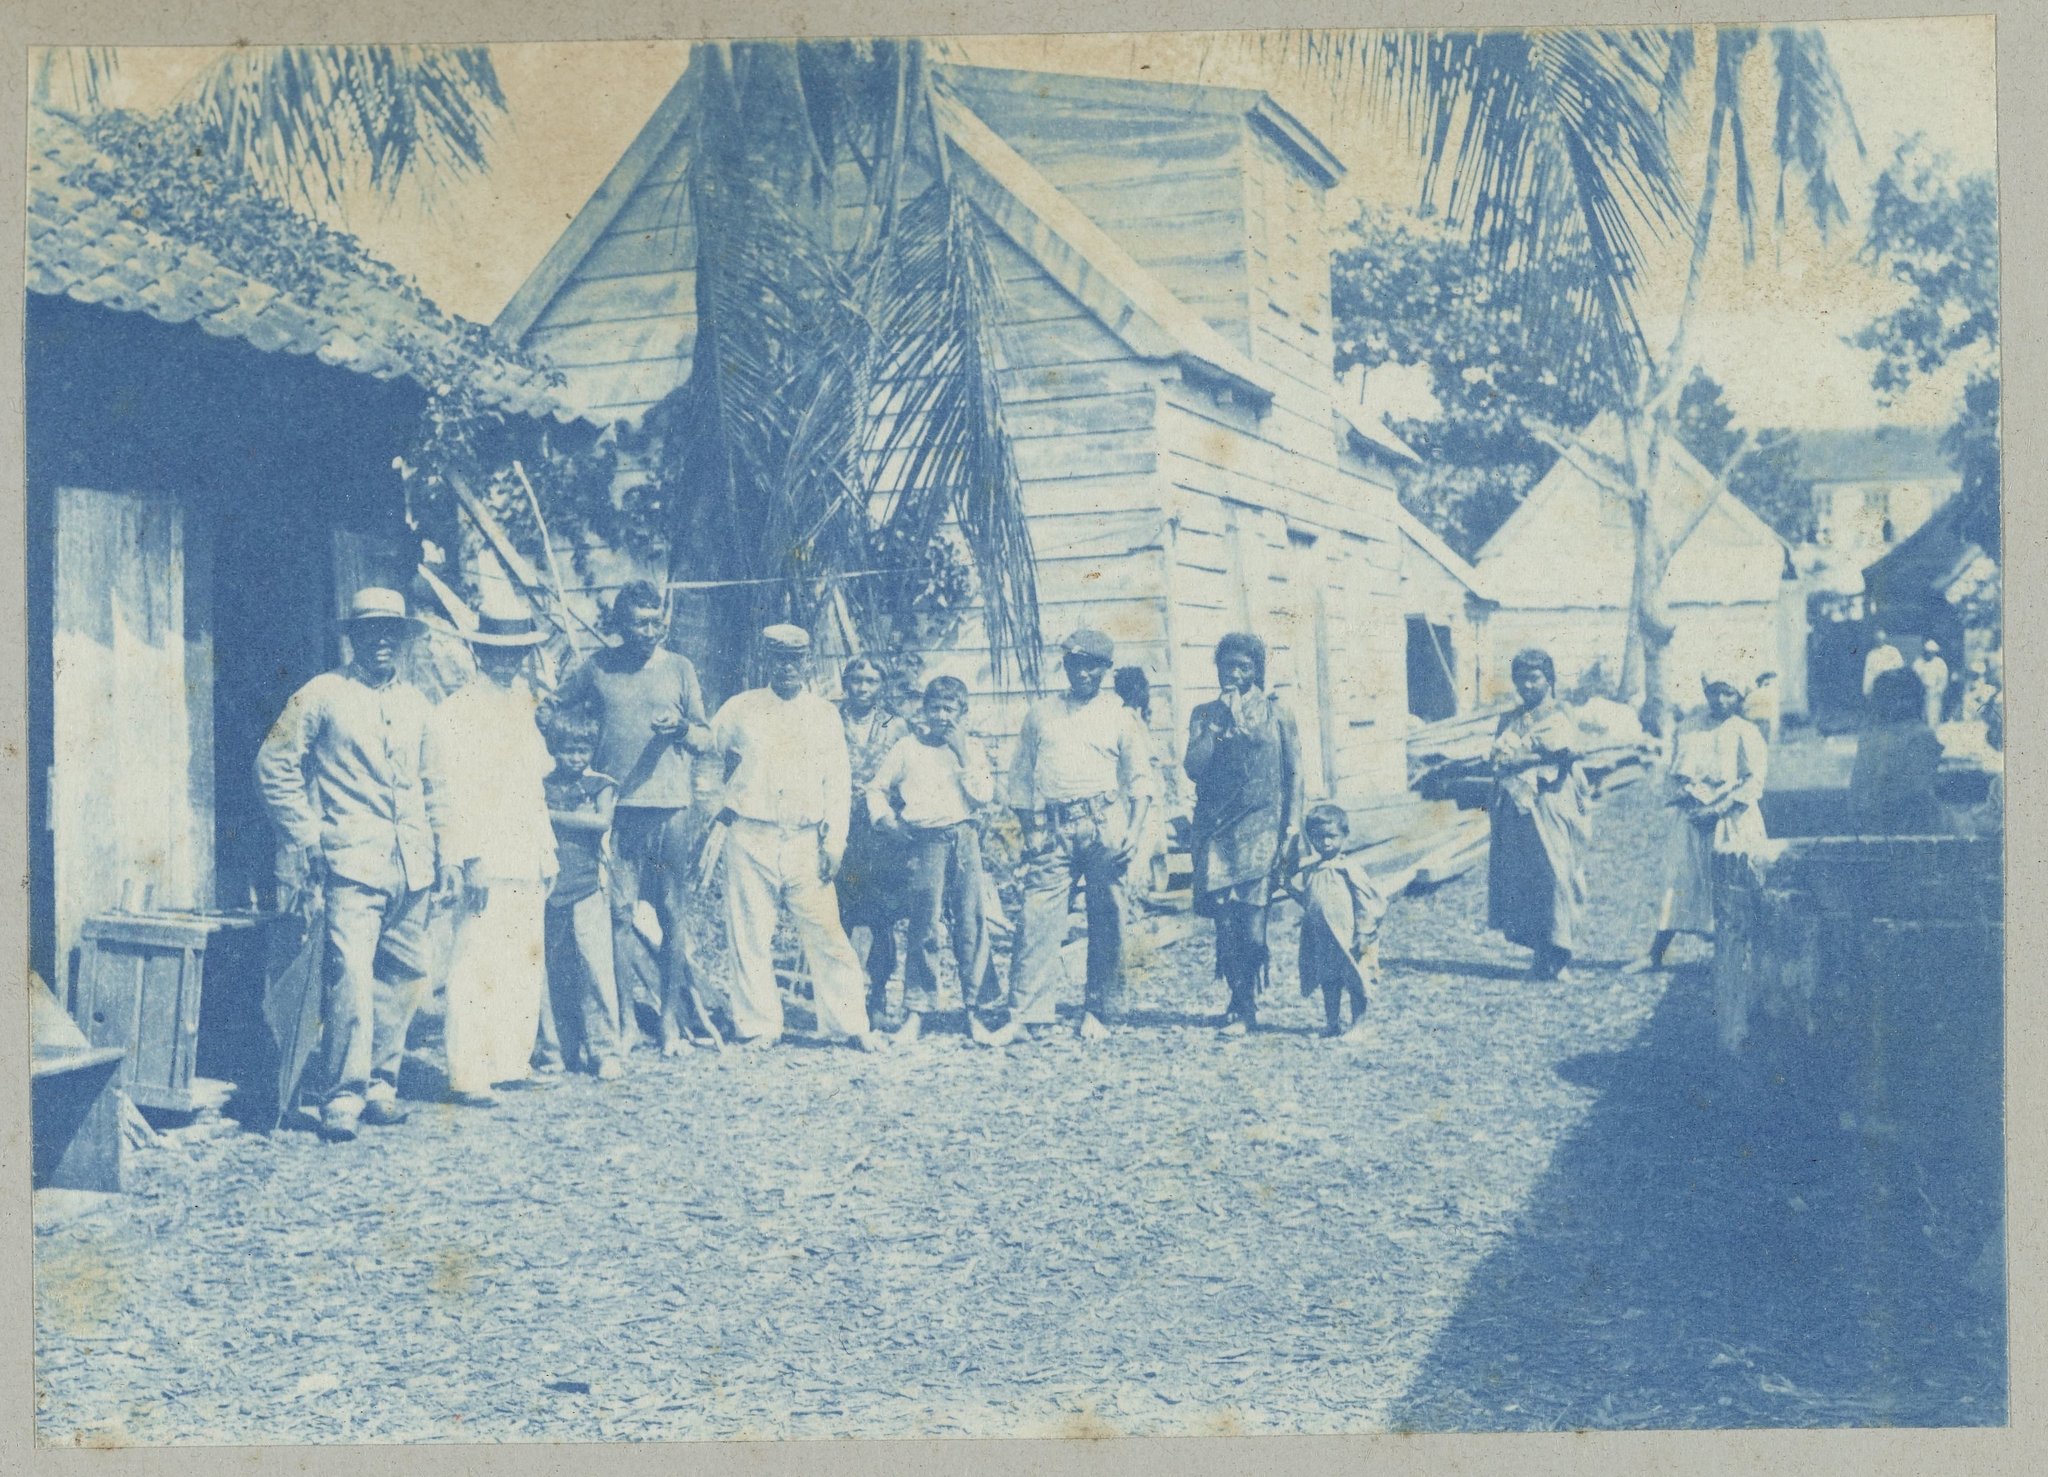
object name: photograph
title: Surinaamse Caraïben op een erf in de Saramaccastraat, Paramaribo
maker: hendrik doijer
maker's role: engineer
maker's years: 1863-1925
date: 1903-1910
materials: photographic support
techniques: cyanotype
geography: suriname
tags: indigenous peoples of south america, suriname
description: Gezicht in de Saramaccastraat te Paramaribo, met een groepje poserende Surinaamse Caraïben. Wanneer de Caraïben naar Paramaribo kwamen, verbleven zij vaak in de Sarammacastraat, dichtbij de Surinamerivier waarover zij aankwamen. Onderdeel van het fotoalbum van de familie Doijer, Souvenir de Voyage (deel 1), in en rond de plantage Ma Retraite in Suriname in de jaren 1903-1910.